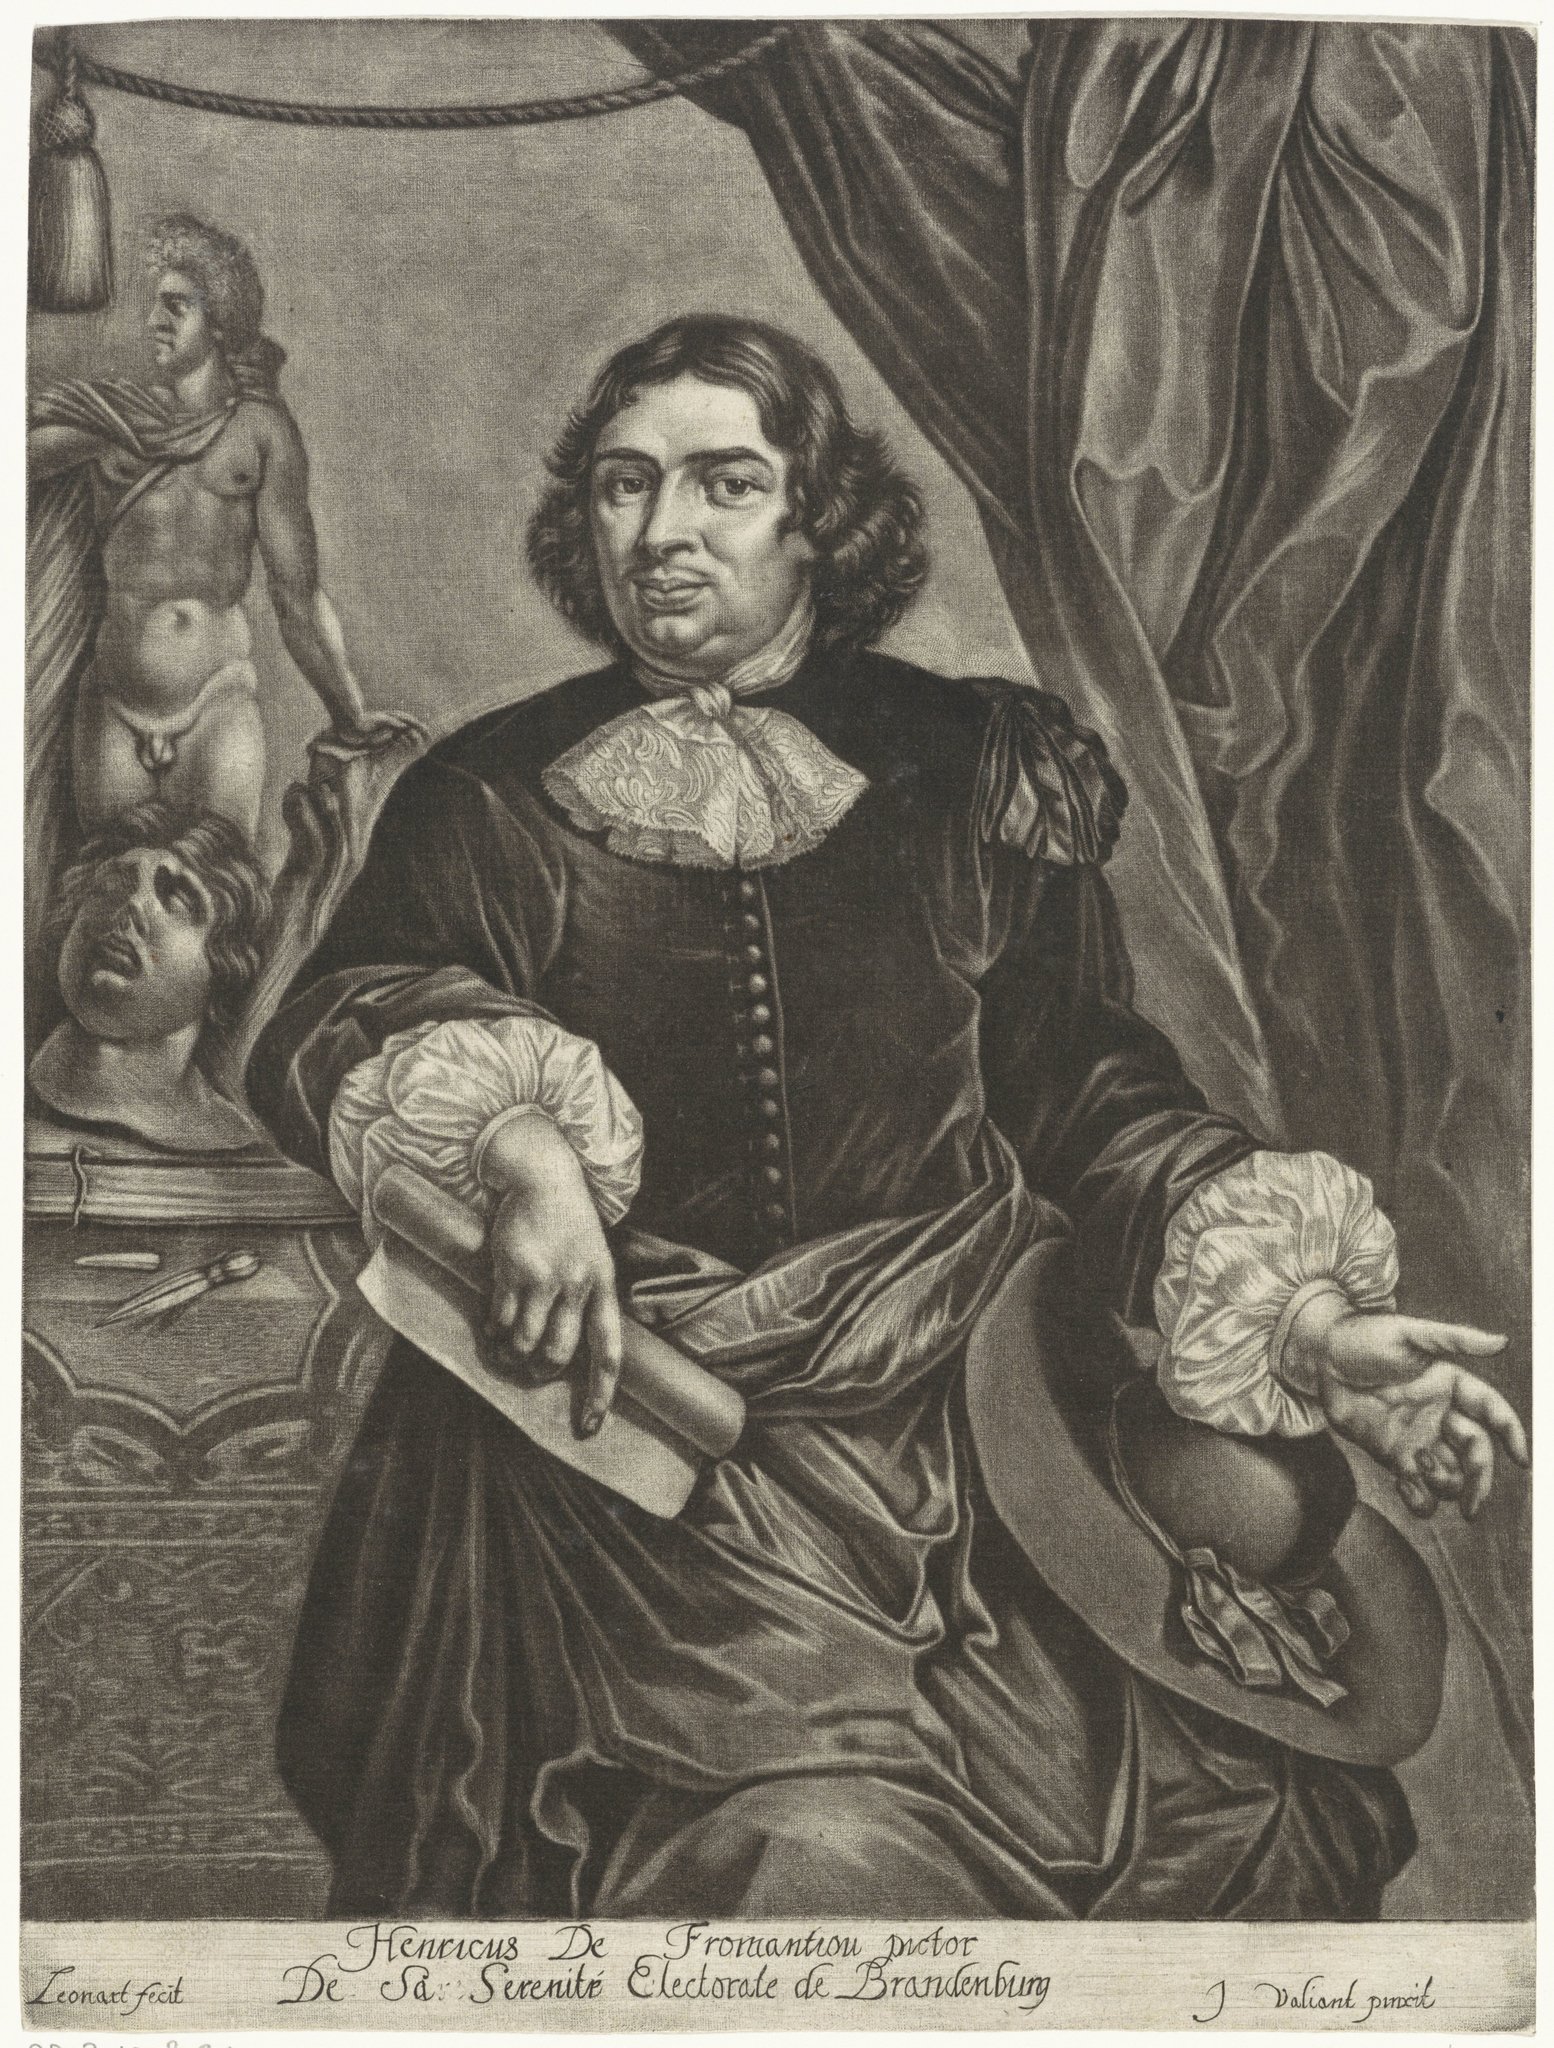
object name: print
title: Portret van Henrik de Fromantiou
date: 1653-1680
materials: paper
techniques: engraving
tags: gallery of sculptures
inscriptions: collector's mark: Lugt 2228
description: De stillevenschilder Henrik de Fromantiou met in de hand een rol papier en op de achtergrond twee sculpturen. Hij was vanaf 1670 conservator van de kunstcollectie van de hertog van Brandenburg.